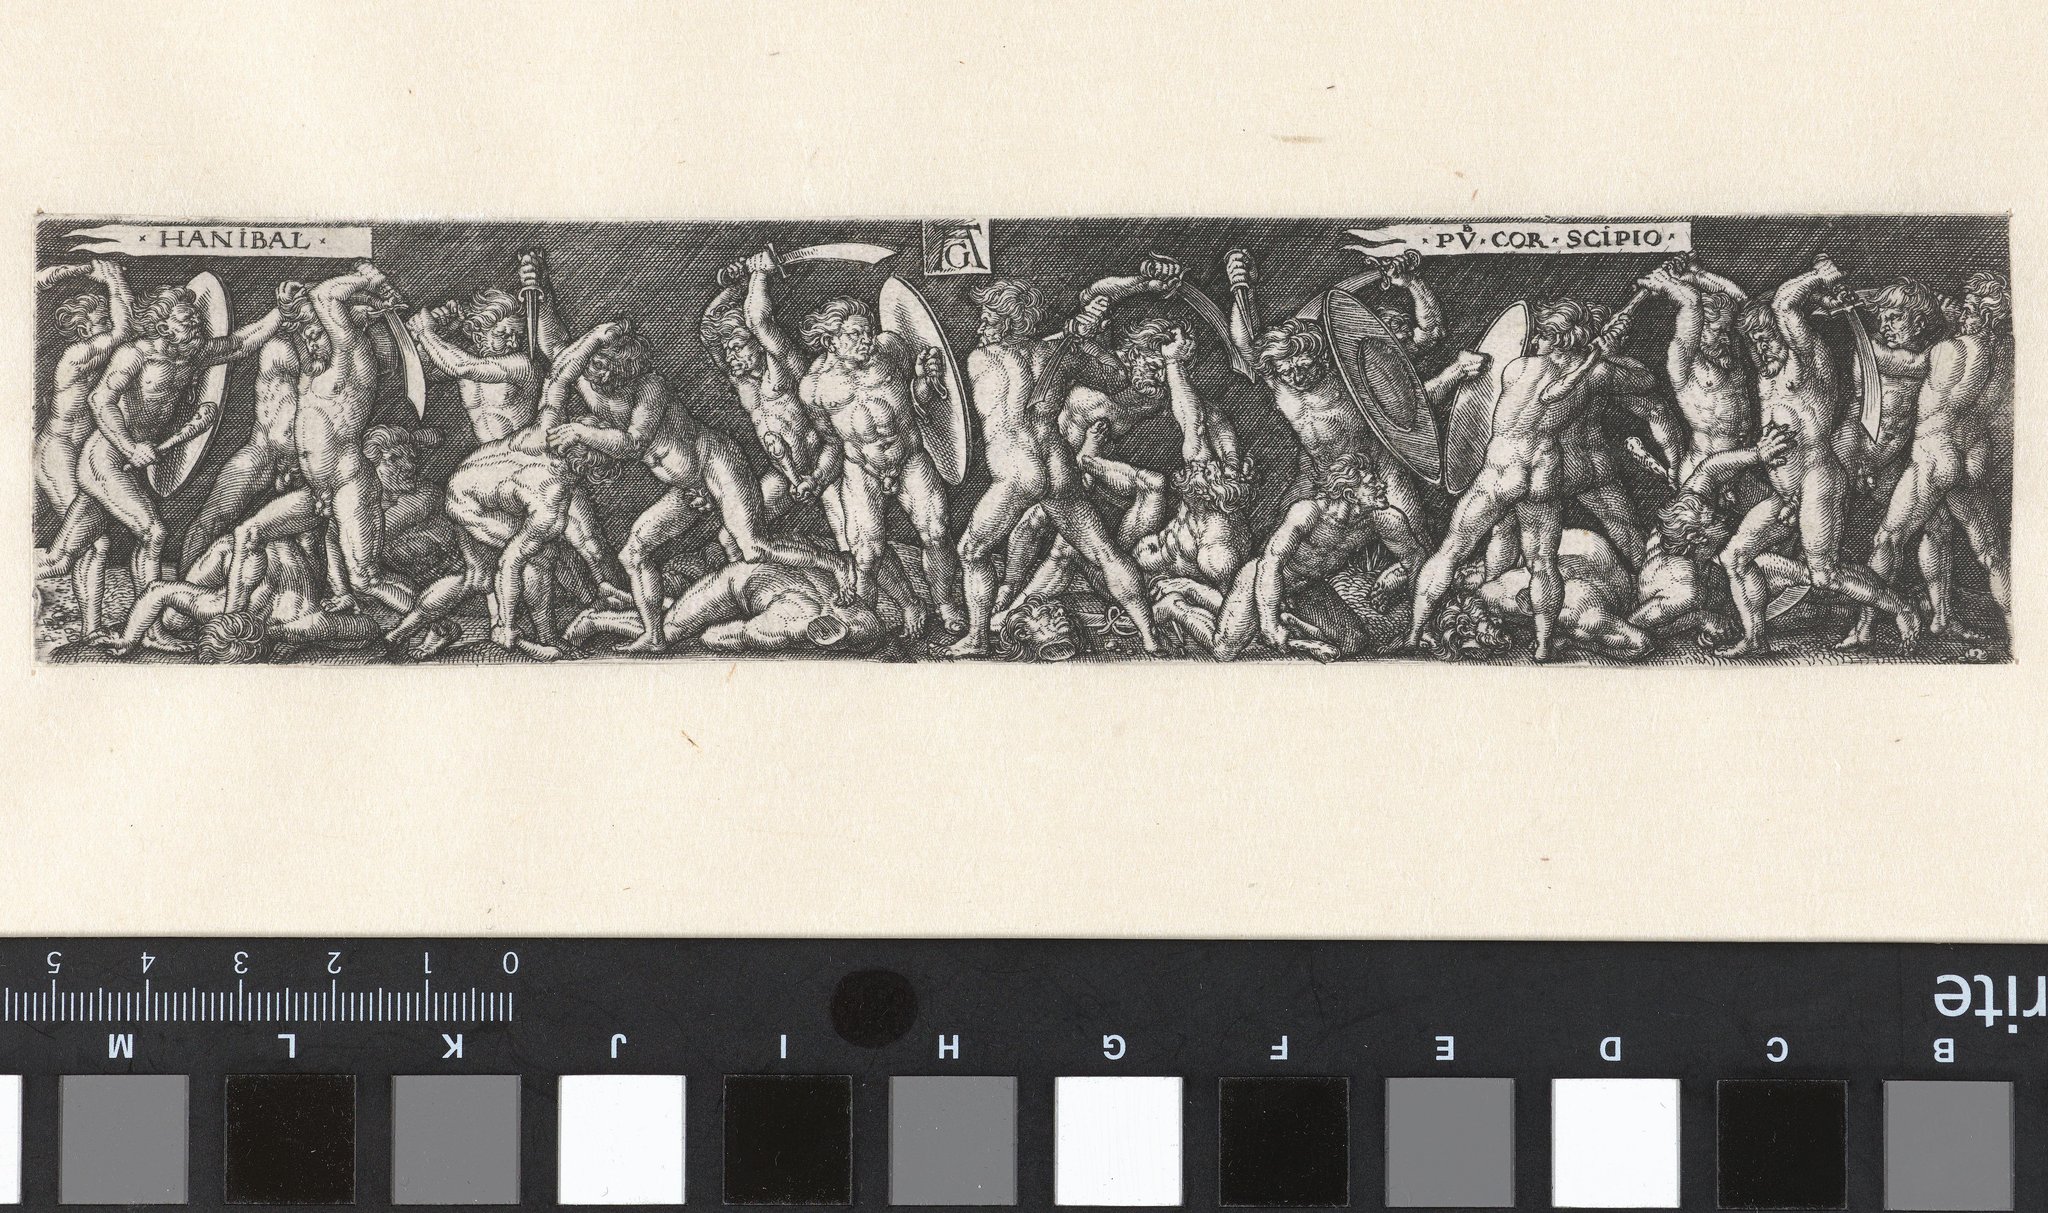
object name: print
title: Hanibal pu cor Scipio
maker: heinrich aldegrever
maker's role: draughtsman, print maker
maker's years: 1502-1561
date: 1538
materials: paper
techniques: engraving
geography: germany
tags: the meeting of scipio and hannibal before the battle of zama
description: Hannibal en zijn mannen vechten met knotsen en zwaarden tegen Scipio en zijn mannen, allen zijn naakt.